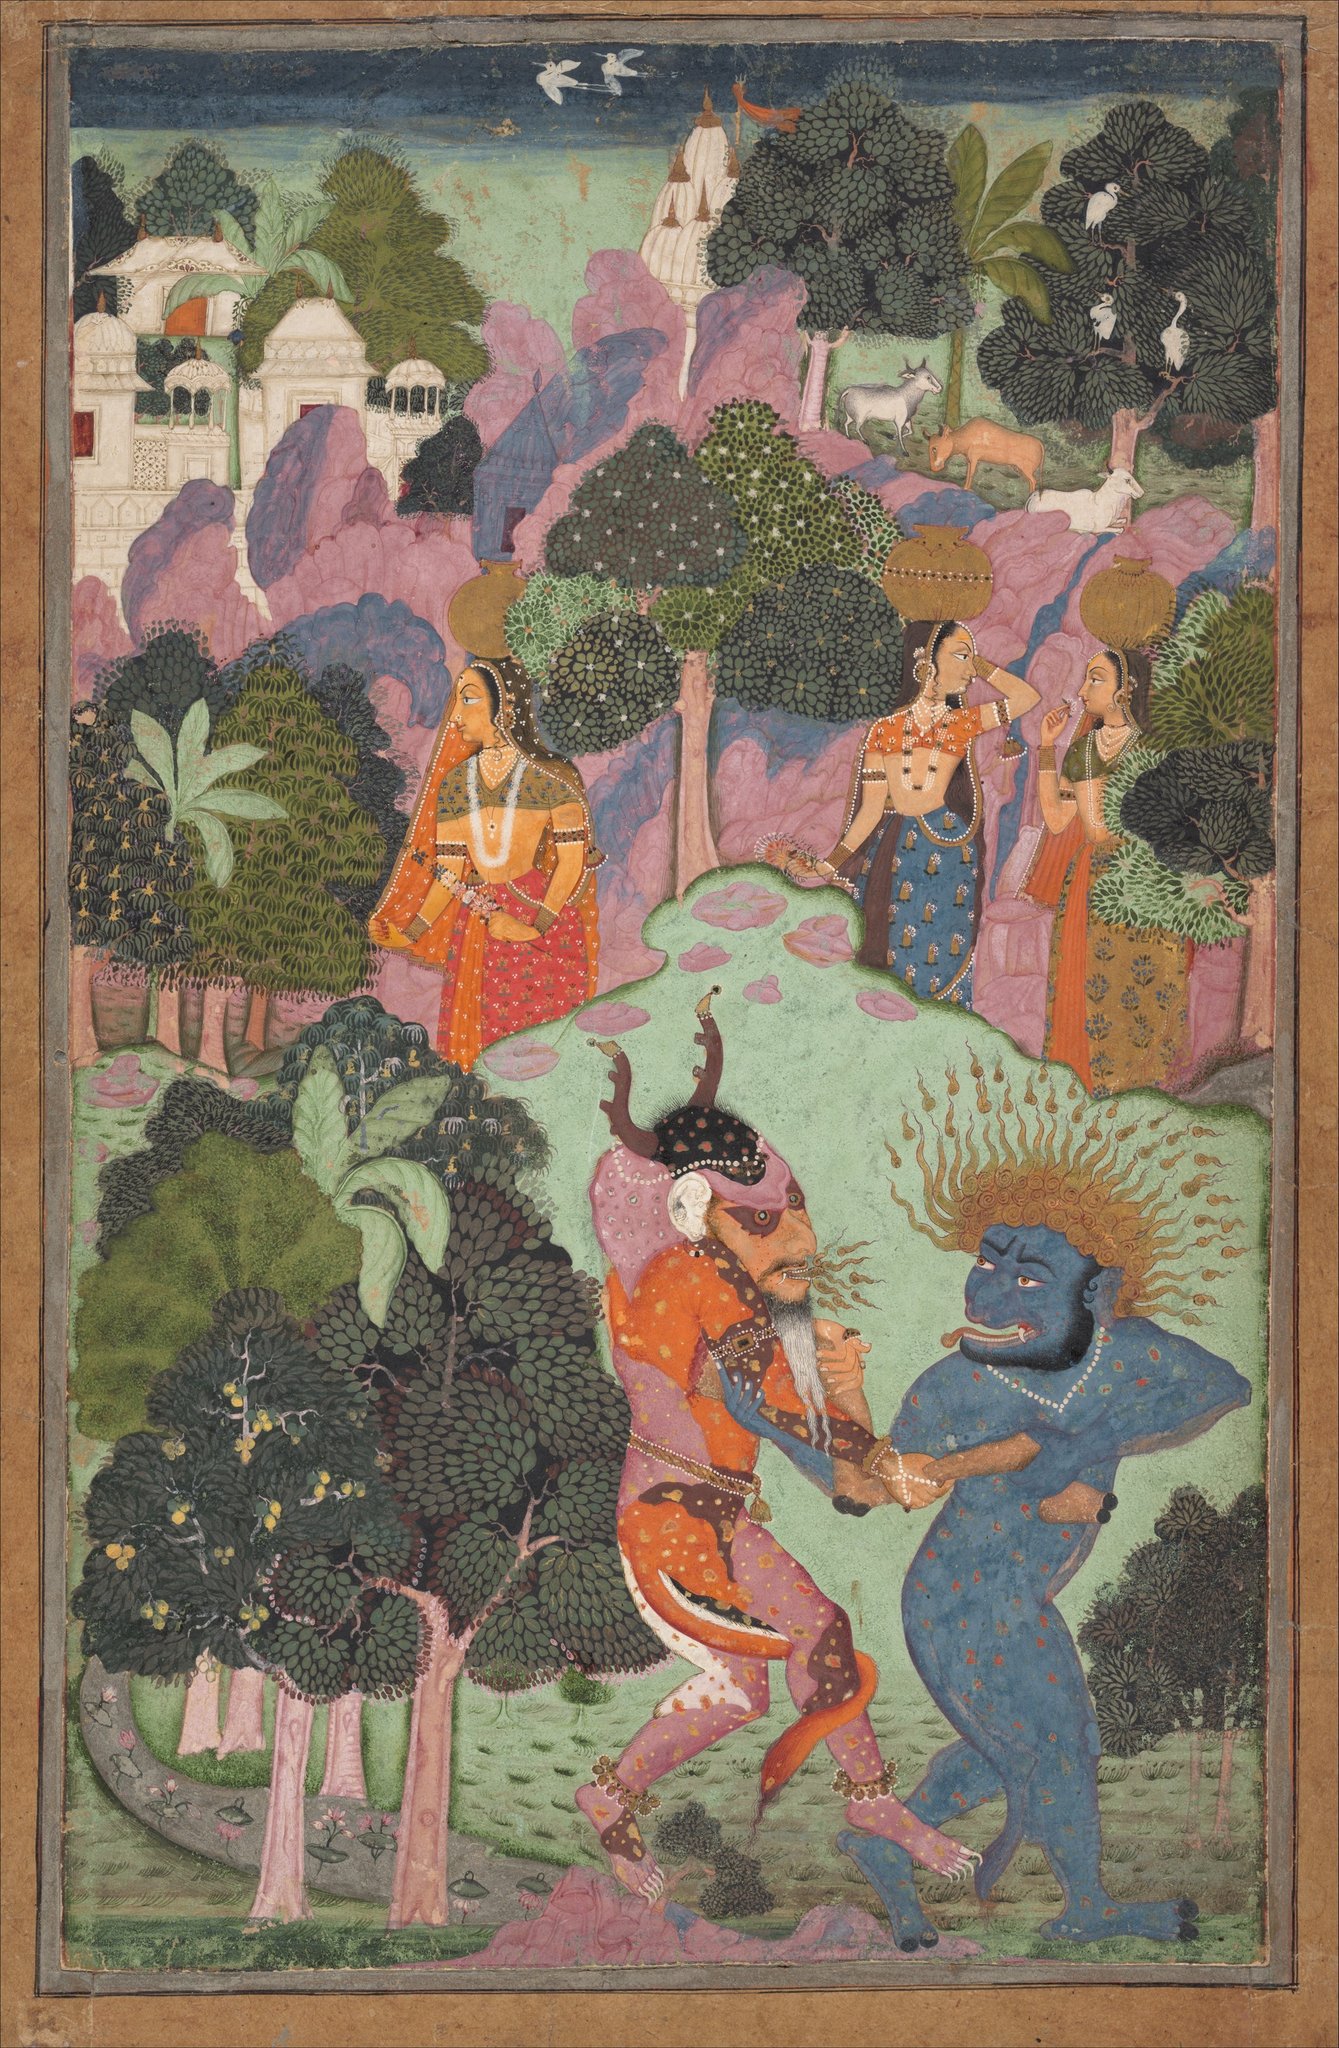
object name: painting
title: Demons Fighting Over an Animal Limb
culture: indian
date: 1667-1700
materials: gold, ink, paper, watercolor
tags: birds,houses,women,cows,landscapes,demons